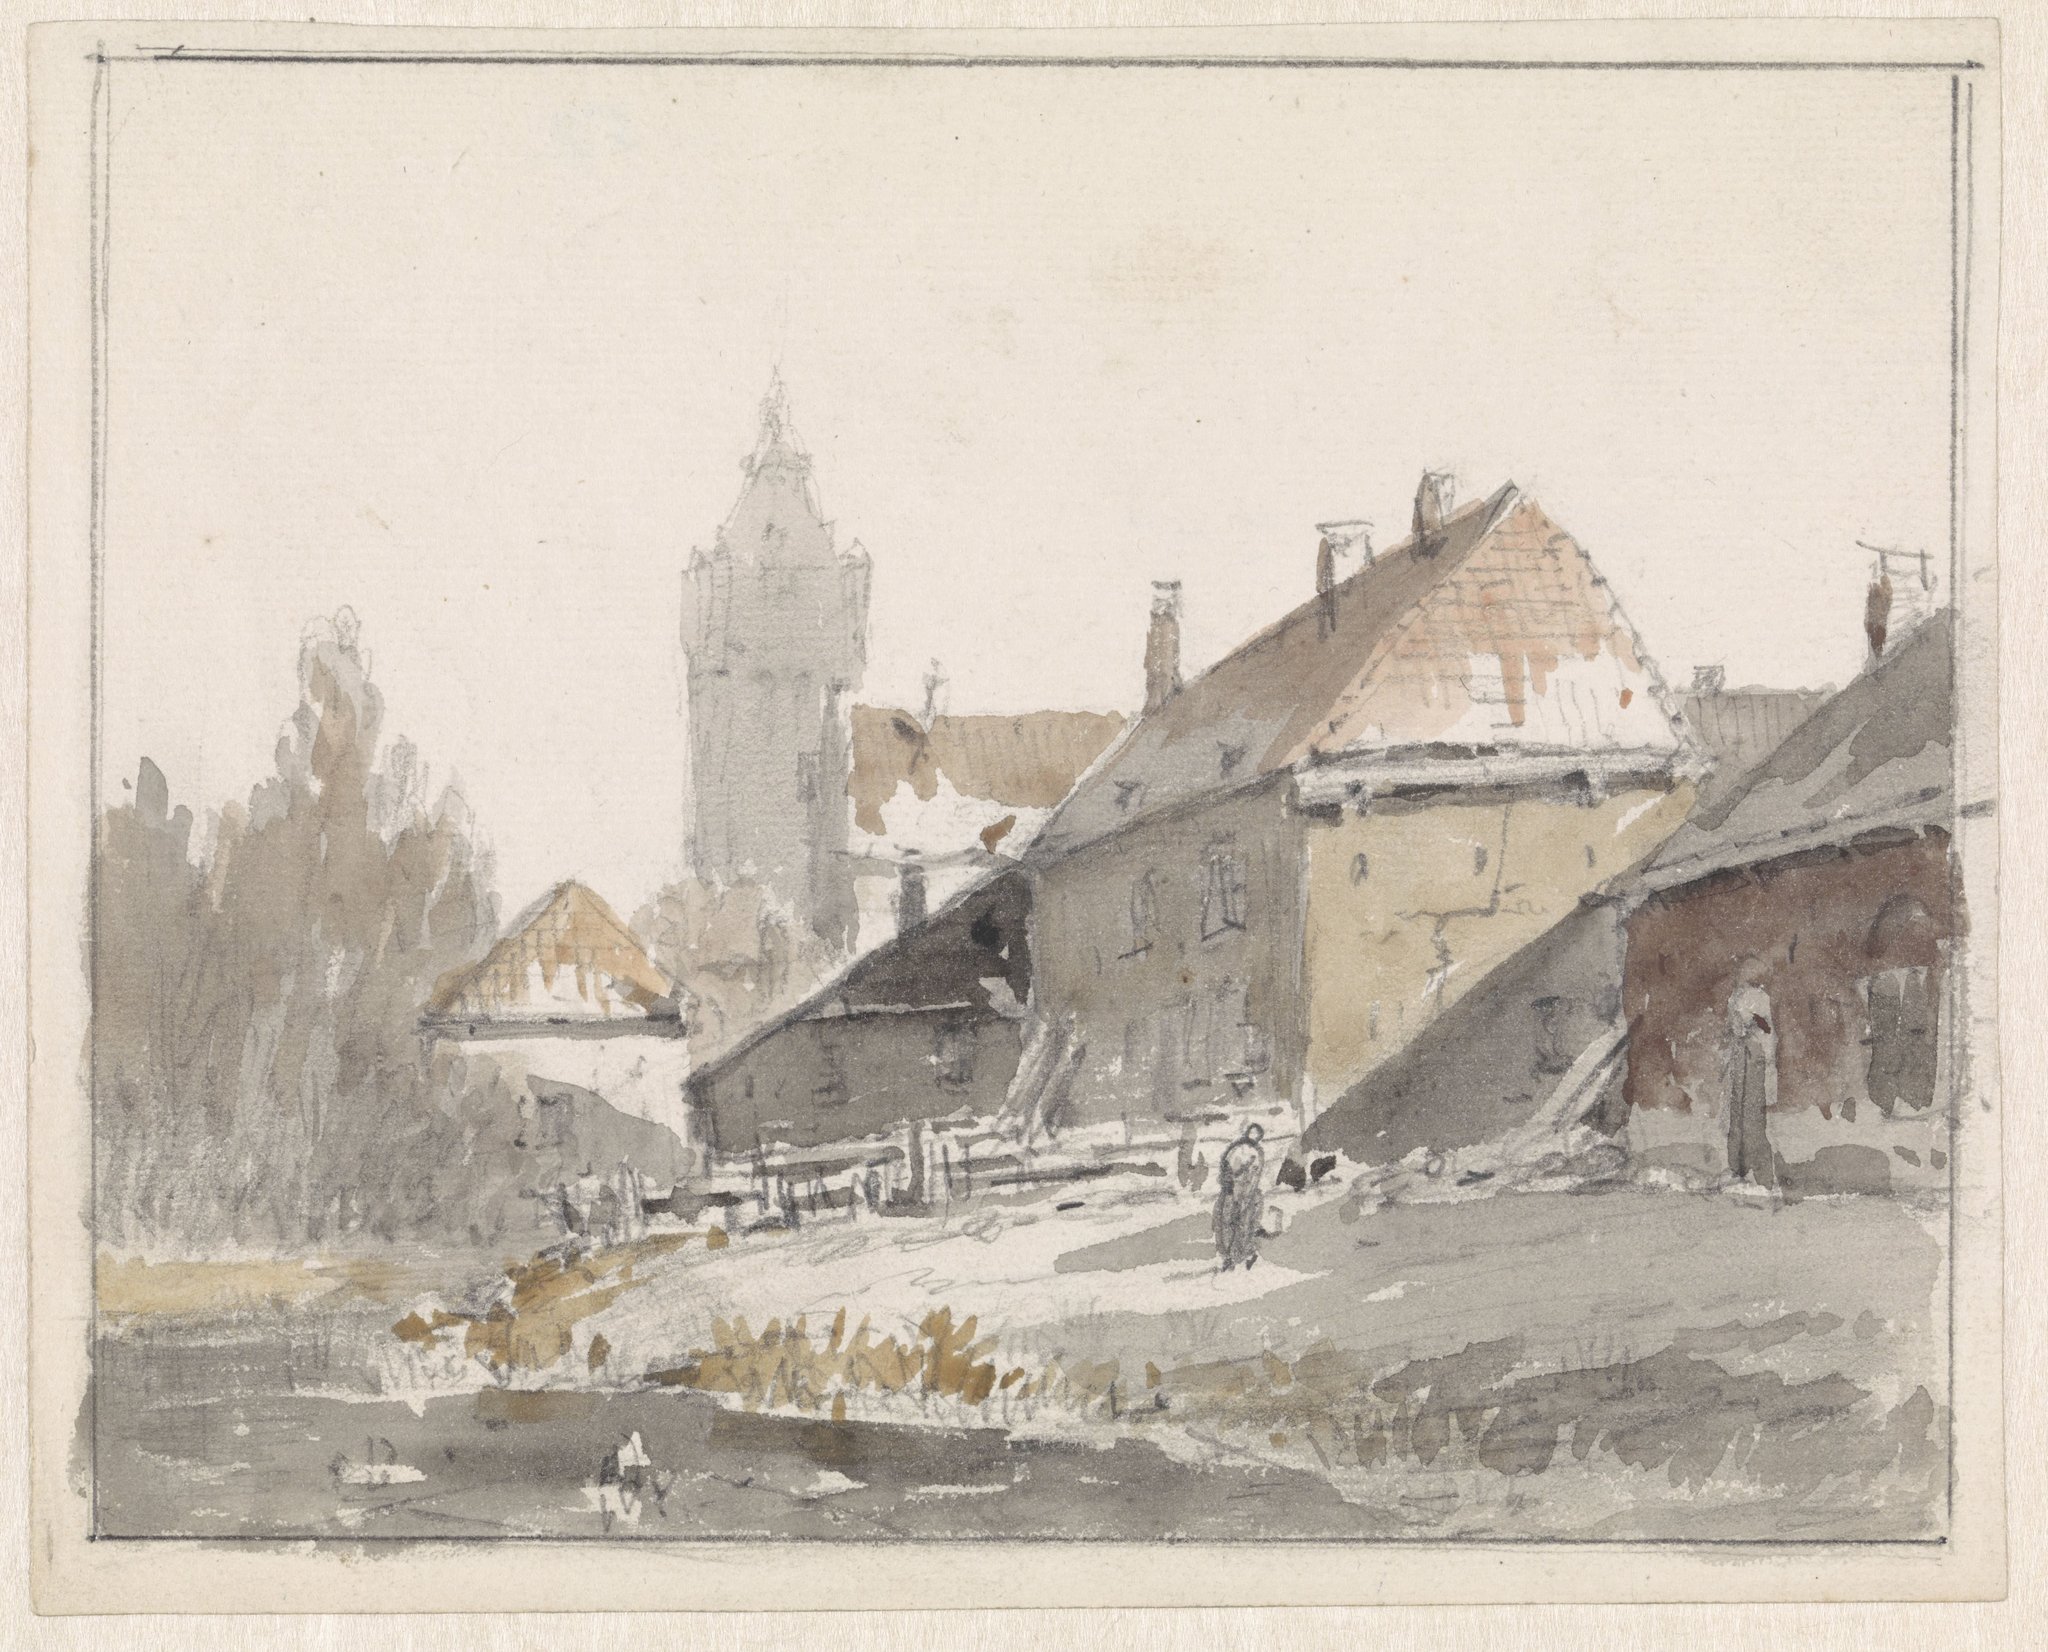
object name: drawing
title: Gezicht op huizen aan de rand van een stad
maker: adrianus eversen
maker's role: draughtsman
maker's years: 1818-1897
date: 1828-1897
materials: paper, pencil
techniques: brush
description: Gezicht op huizen aan de rand van een stad, in het verschiet een kerktoren.